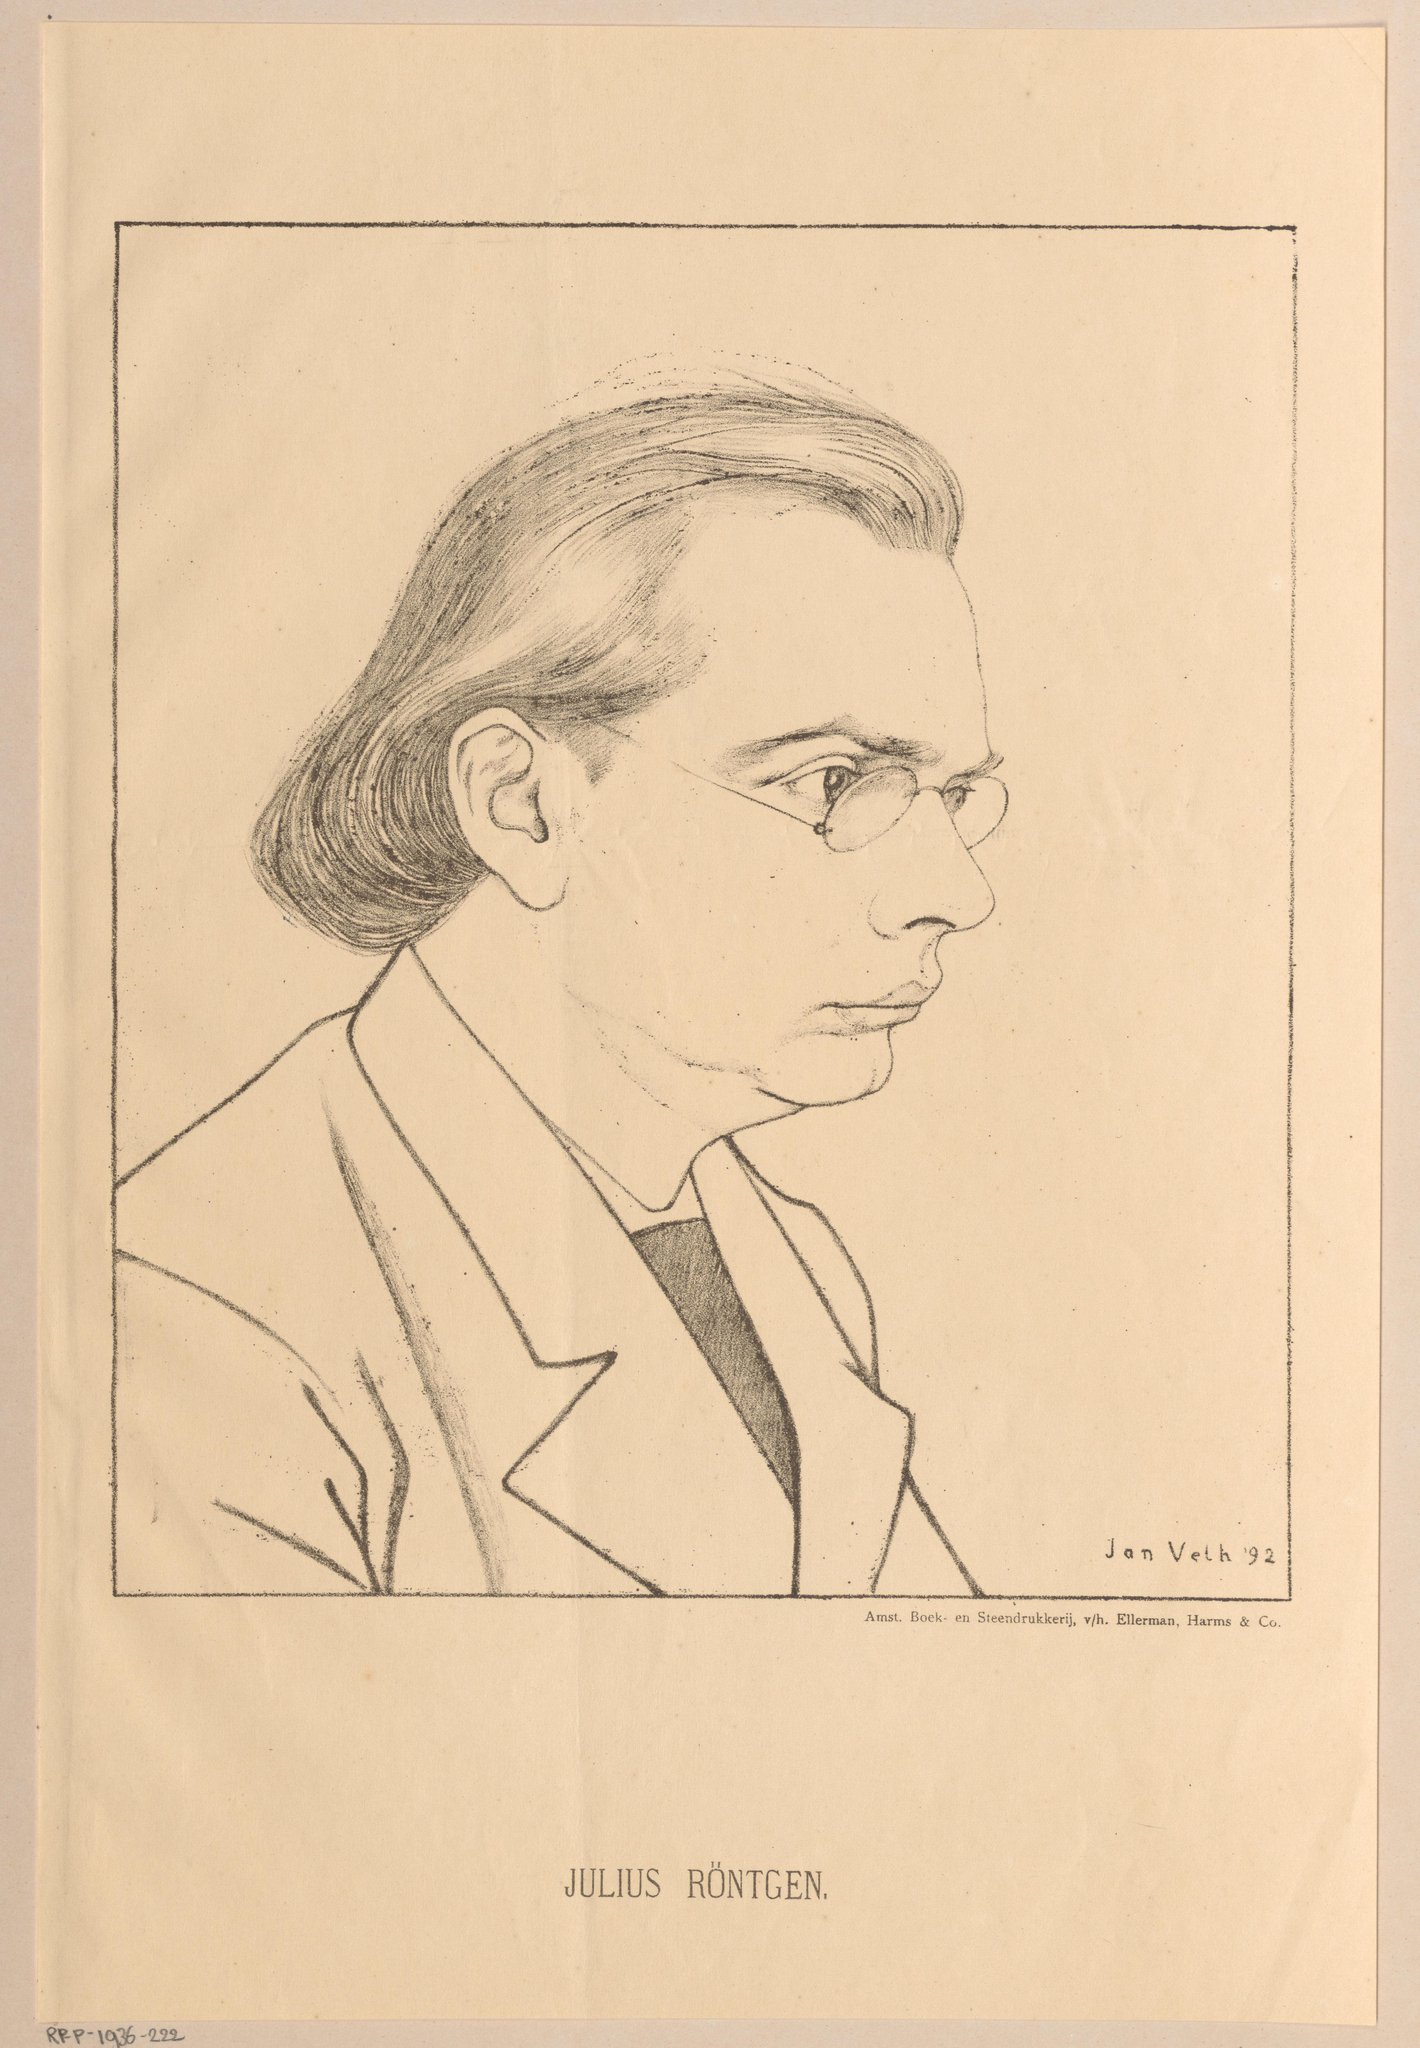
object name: print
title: Portret van Julius Röntgen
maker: jan veth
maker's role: designer, draughtsman, painter, print maker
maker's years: 1864-1925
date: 1892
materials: paper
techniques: lithograph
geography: amsterdam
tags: utrecht, julius röntgen, historical persons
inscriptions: collector's mark: Lugt 2228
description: Deze prent werd uitgegeven als bijvoegsel van De Amsterdammer op 8 mei 1892.